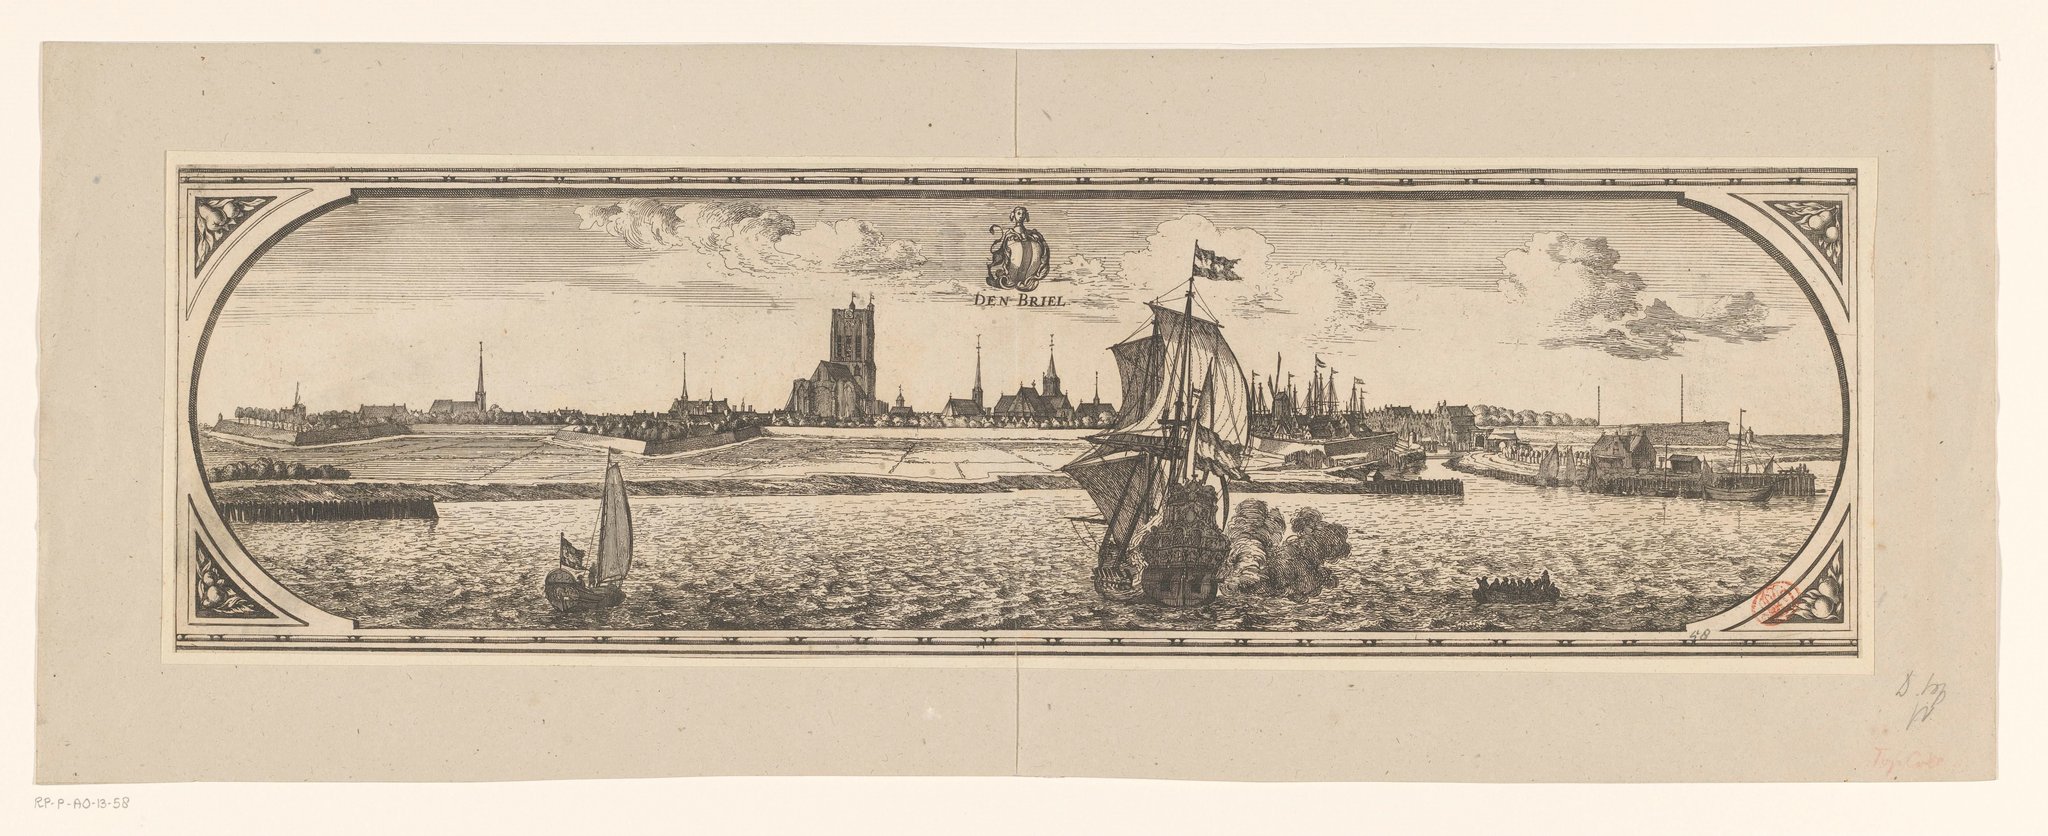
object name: print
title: Gezicht op Brielle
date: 1666-1698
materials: paper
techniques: engraving, etching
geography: rotterdam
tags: coat of arms (as symbol of the state, etc.) (+ city; municipal), sailing-ship, sailing-boat, church (exterior), prospect of city, town panorama, silhouette of city, brielle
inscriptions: collector's mark: Lugt 195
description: Gezicht op Brielle gezien vanaf het water. Links van het midden de Sint-Catharijnekerk, ook wel Grote Kerk genoemd. In het water verschillende zeilschepen. Boven in het midden het wapen van de stad en de titel.